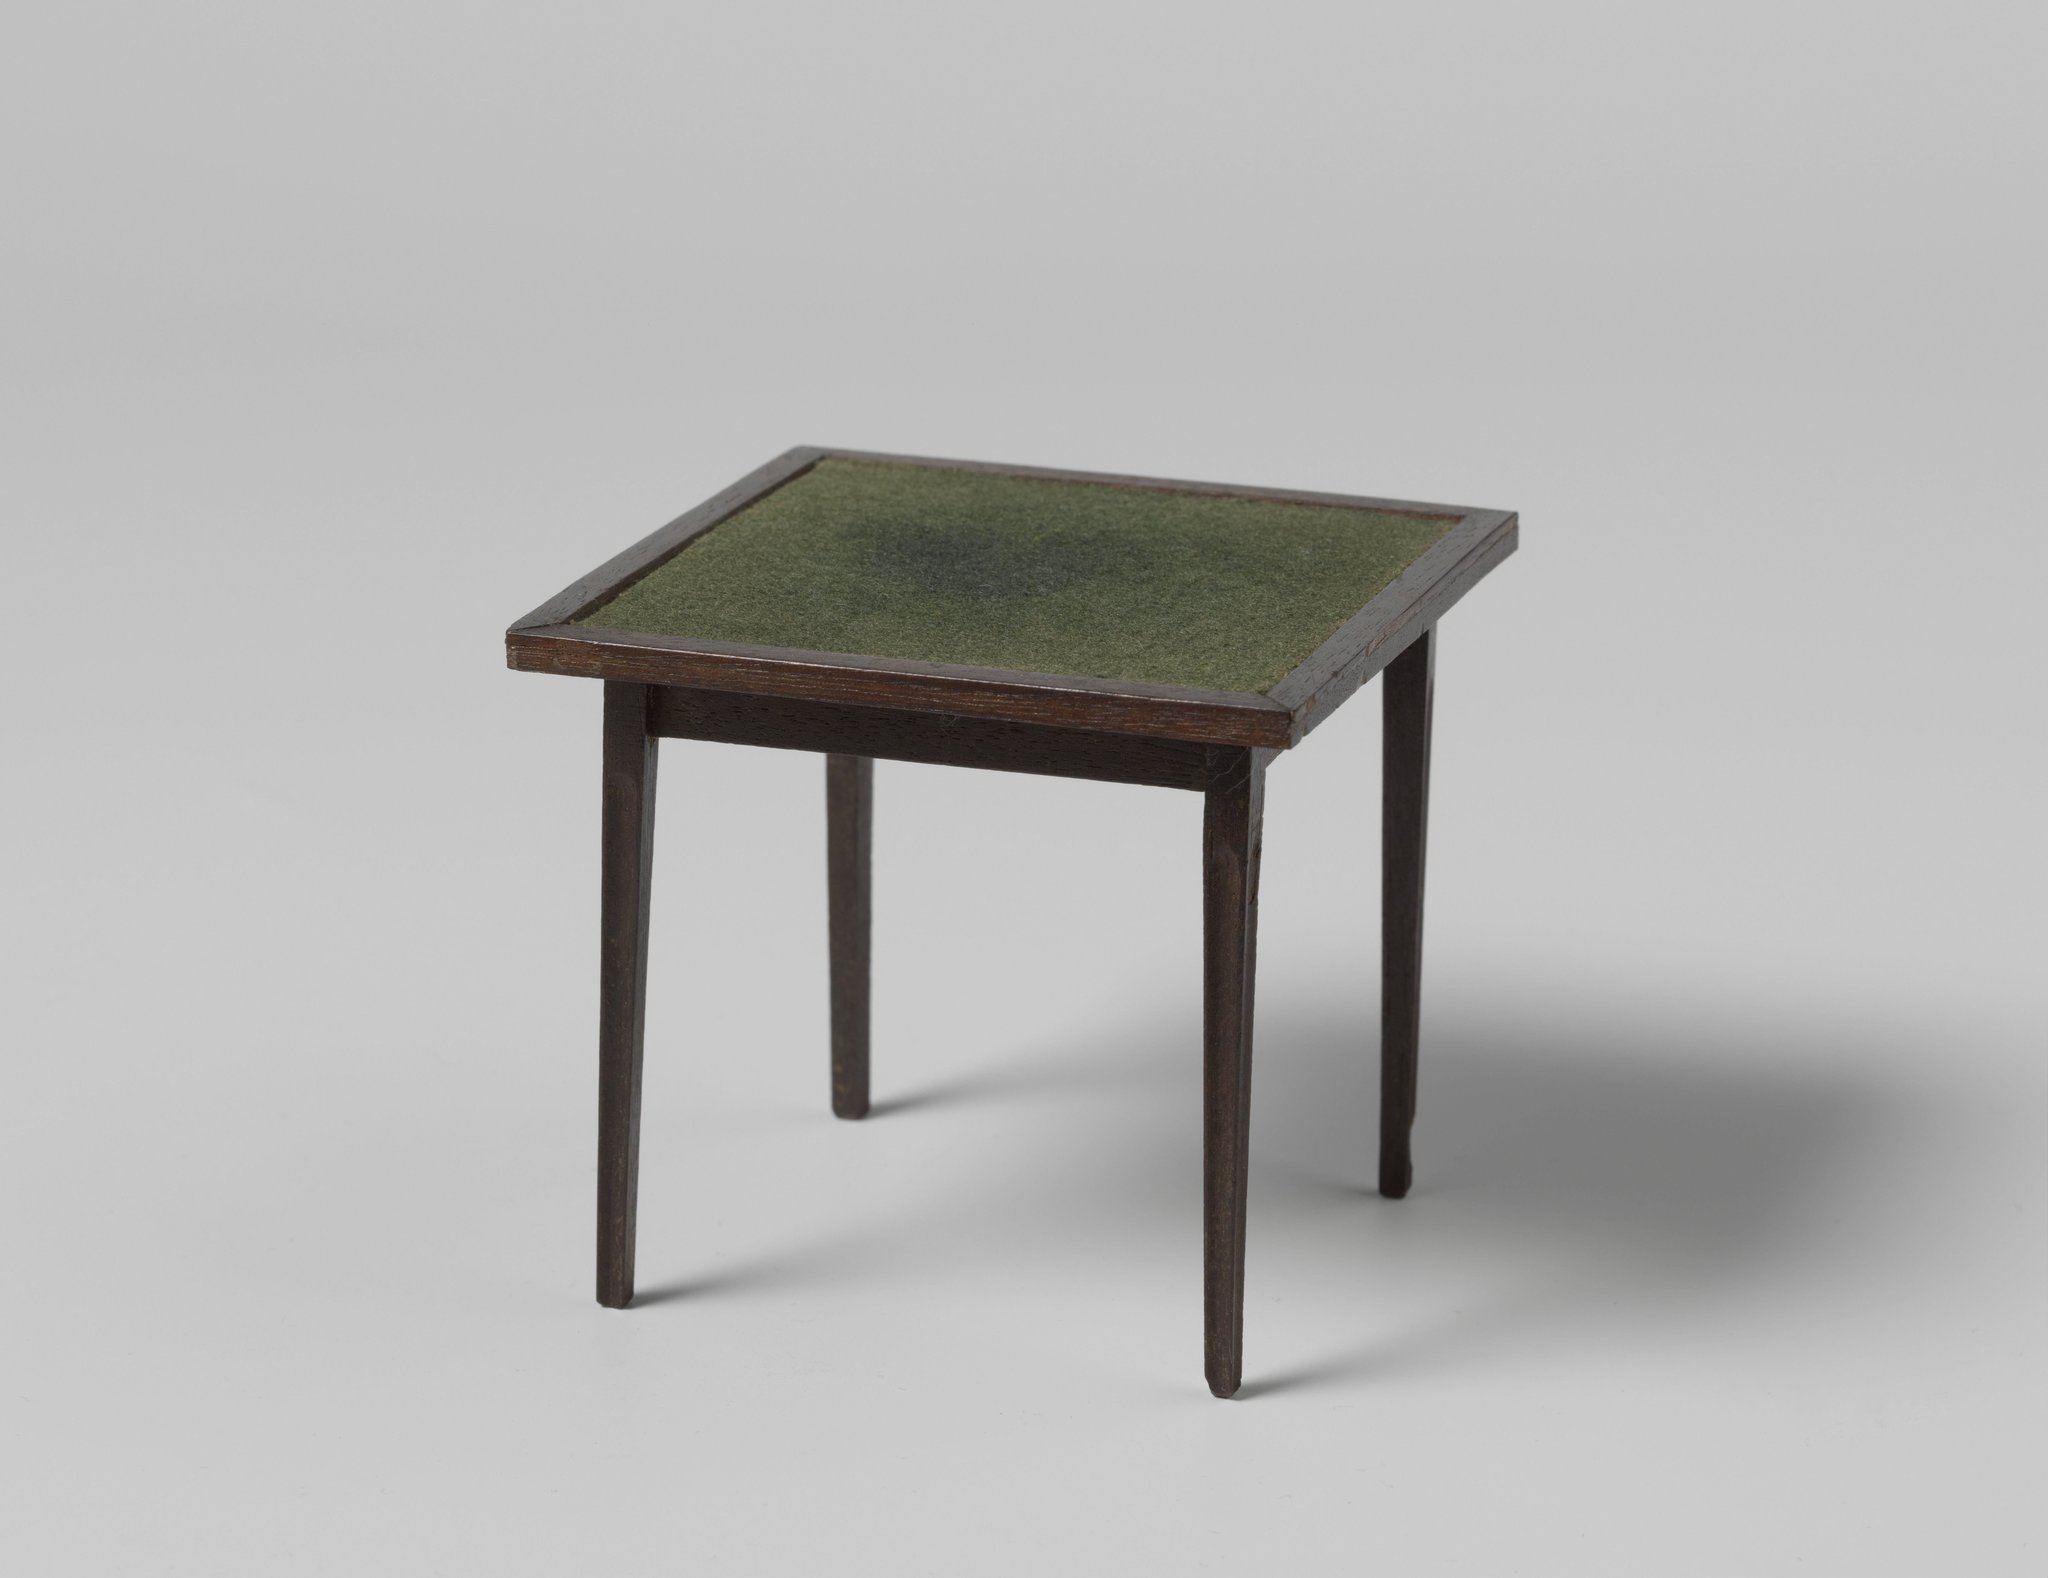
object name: miniature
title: Speeltafel, nagenoeg vierkant, het blad bekleed met groen laken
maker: Anonymous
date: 1775-1800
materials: wood, wool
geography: amsterdam